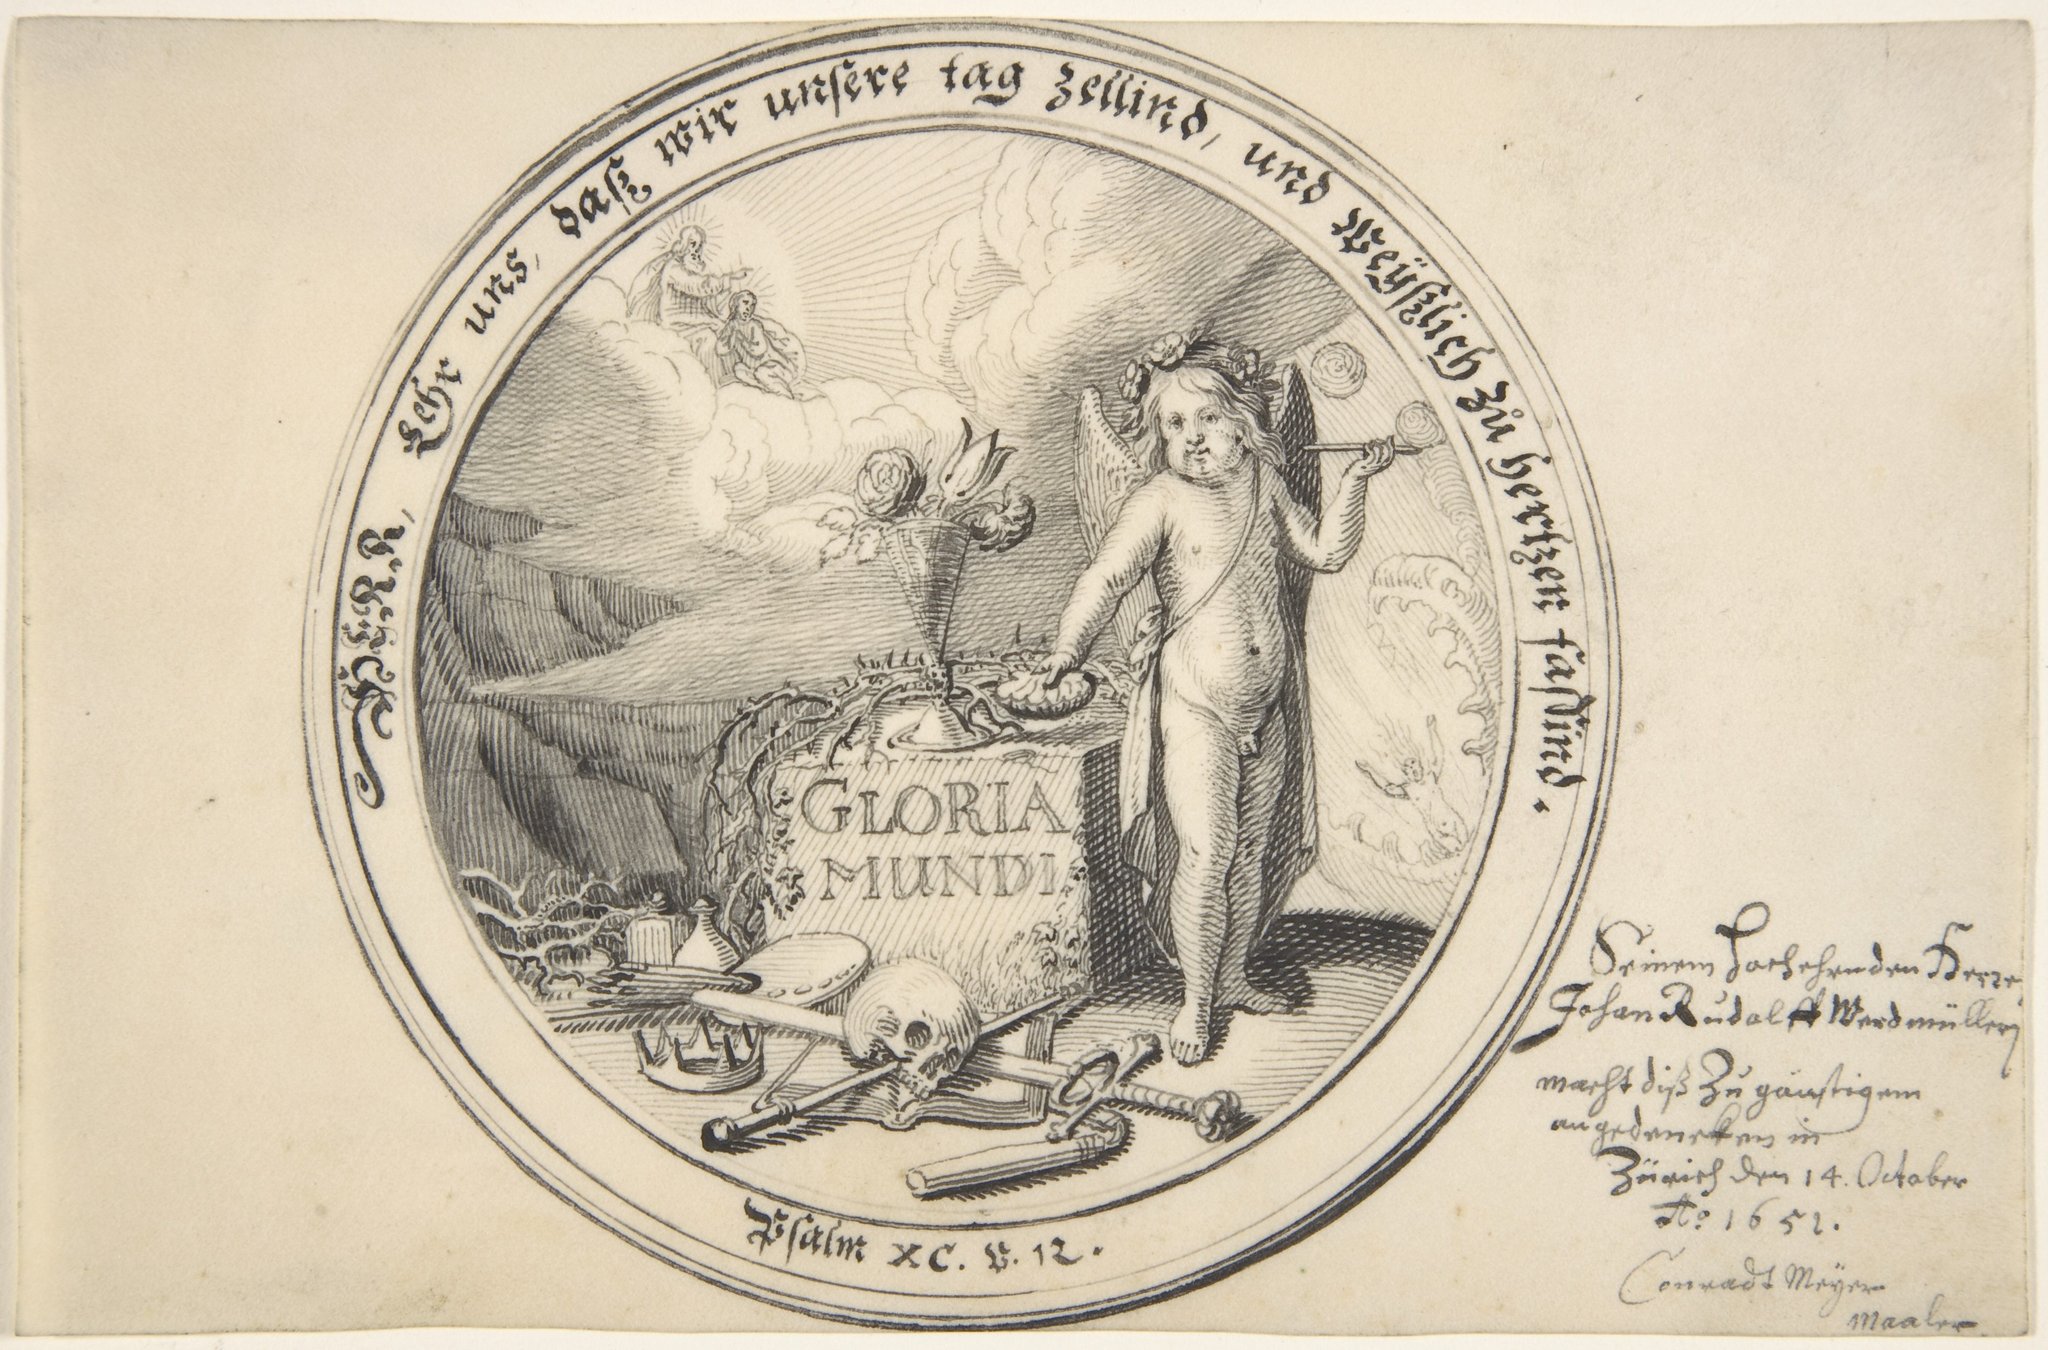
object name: drawing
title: Allegory of the Transience of Life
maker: conrad meyer (i)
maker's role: artist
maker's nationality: swiss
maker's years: 1618-1689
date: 1651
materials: ink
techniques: pen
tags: swords,skulls,flowers,vases